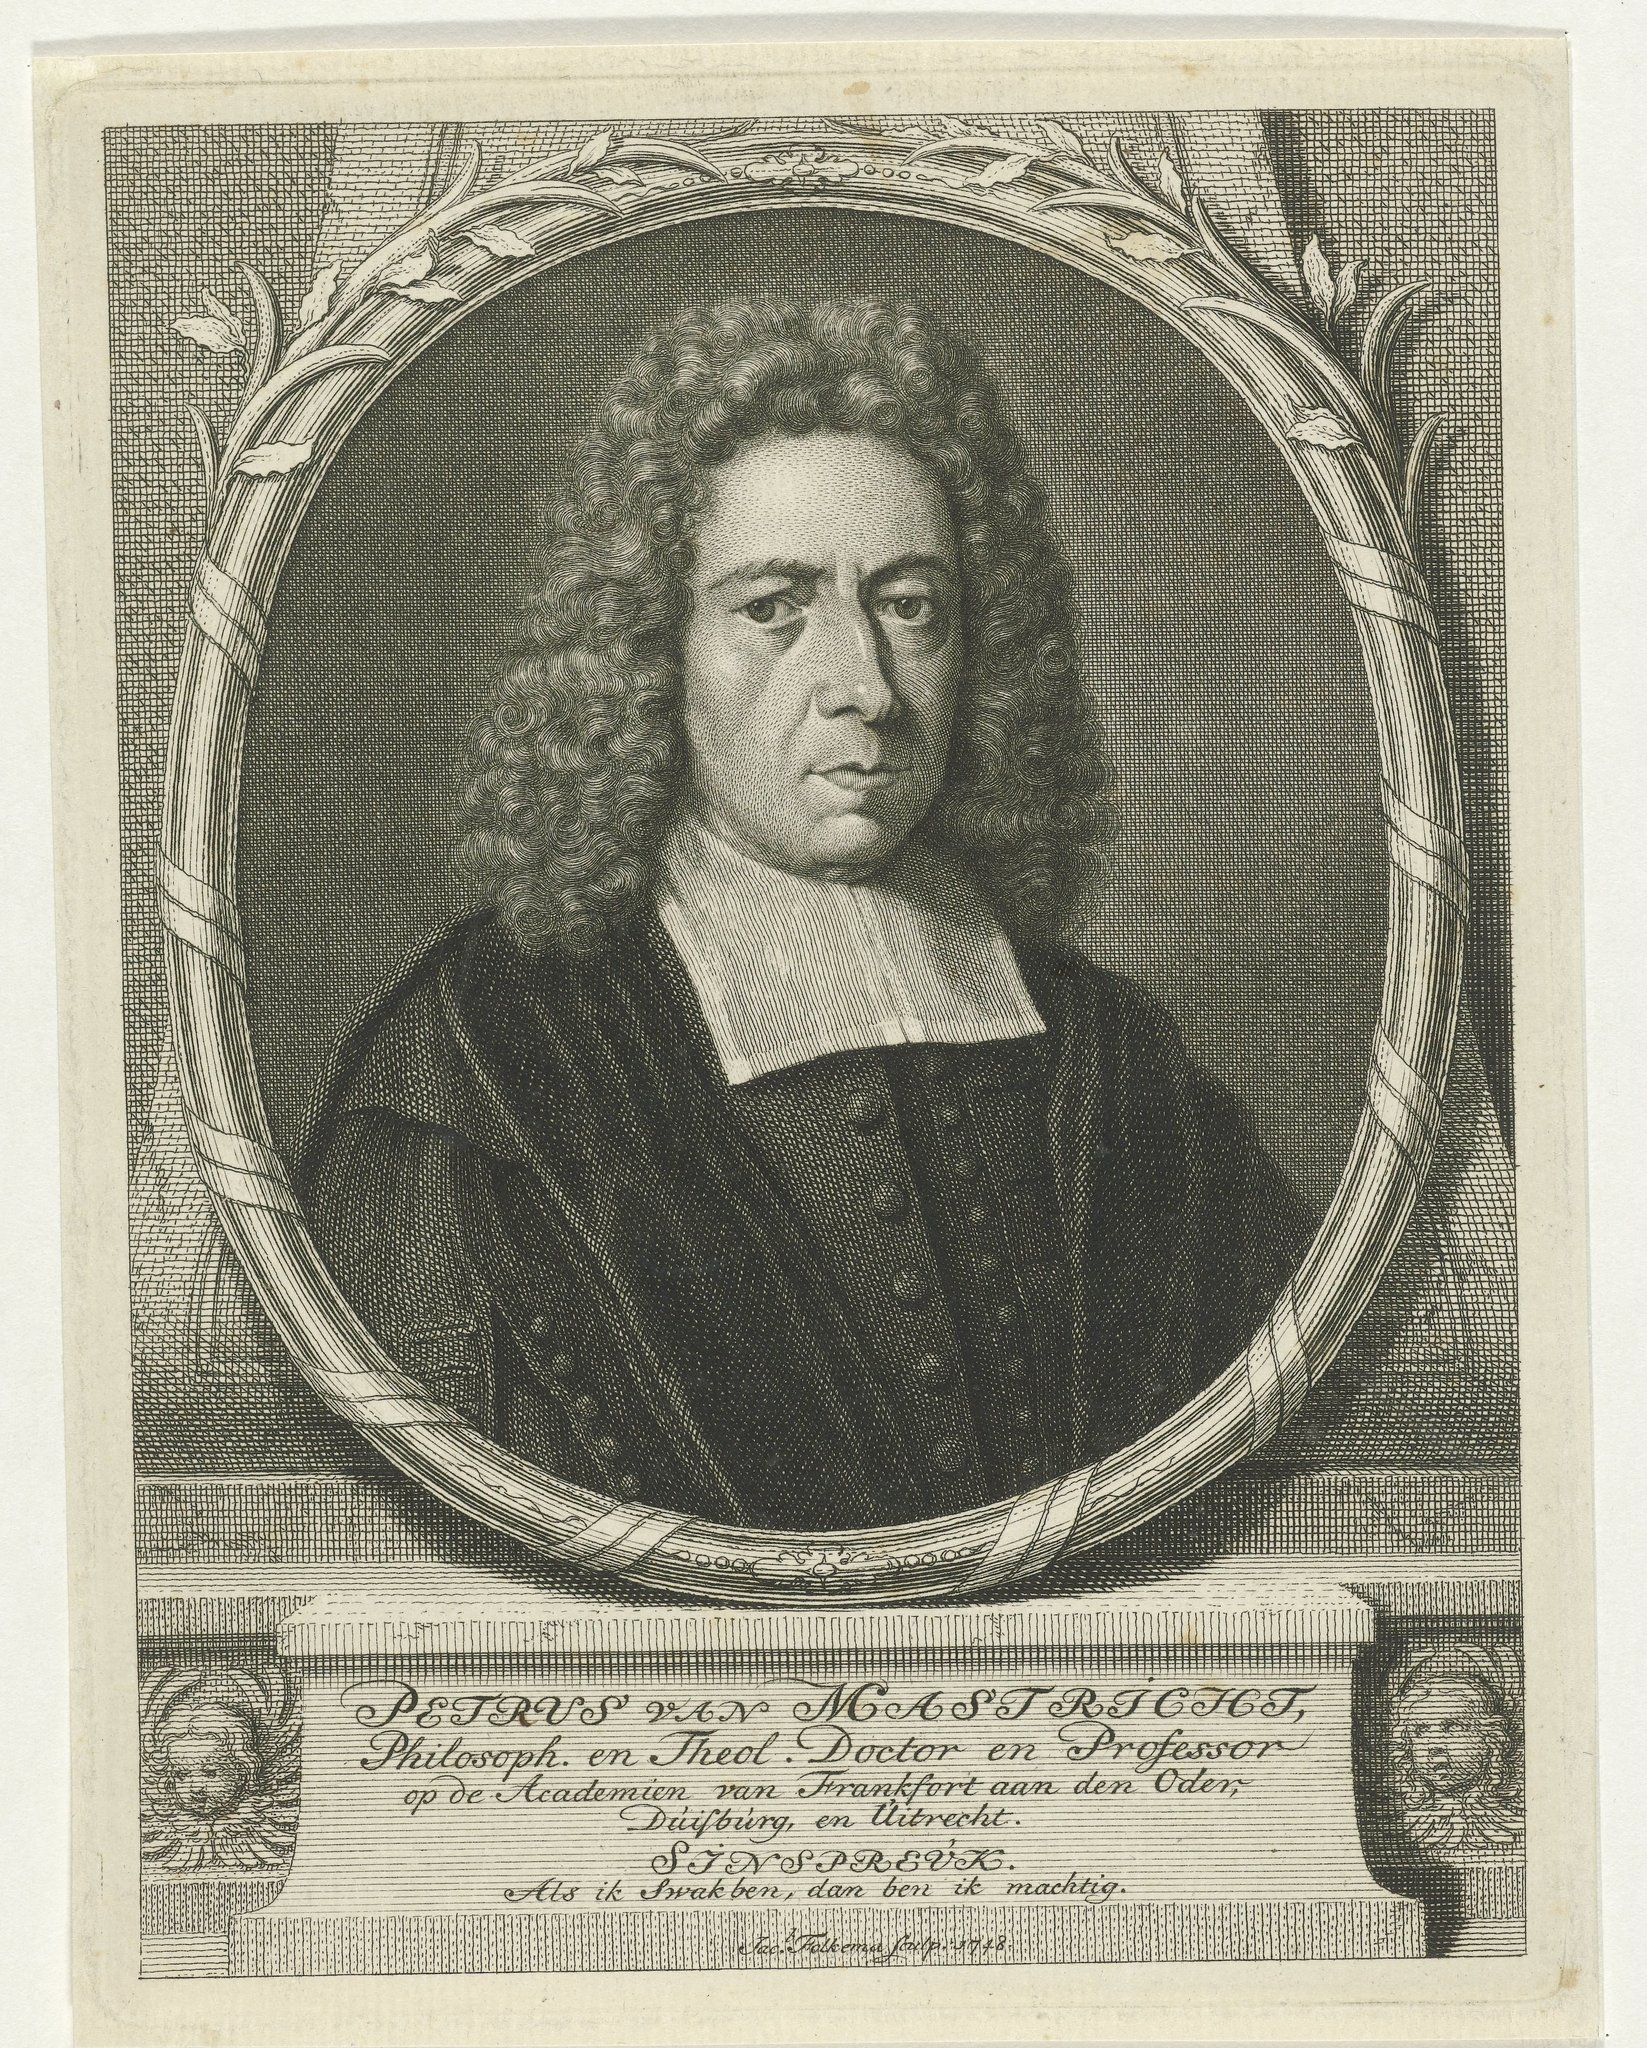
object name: print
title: Portret van Petrus van Mastricht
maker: jacob folkema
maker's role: draughtsman, print maker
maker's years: 1692-1767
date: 1748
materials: paper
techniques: etching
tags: cologne, utrecht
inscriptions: date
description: Portretbuste in ovaal naar rechts van filosoof en theoloog Petrus van Mastricht, blootshoofds en gehuld in een toga. Het portret staat op een sokkel waarop zijn naam, titels en een zinspreuk staan.